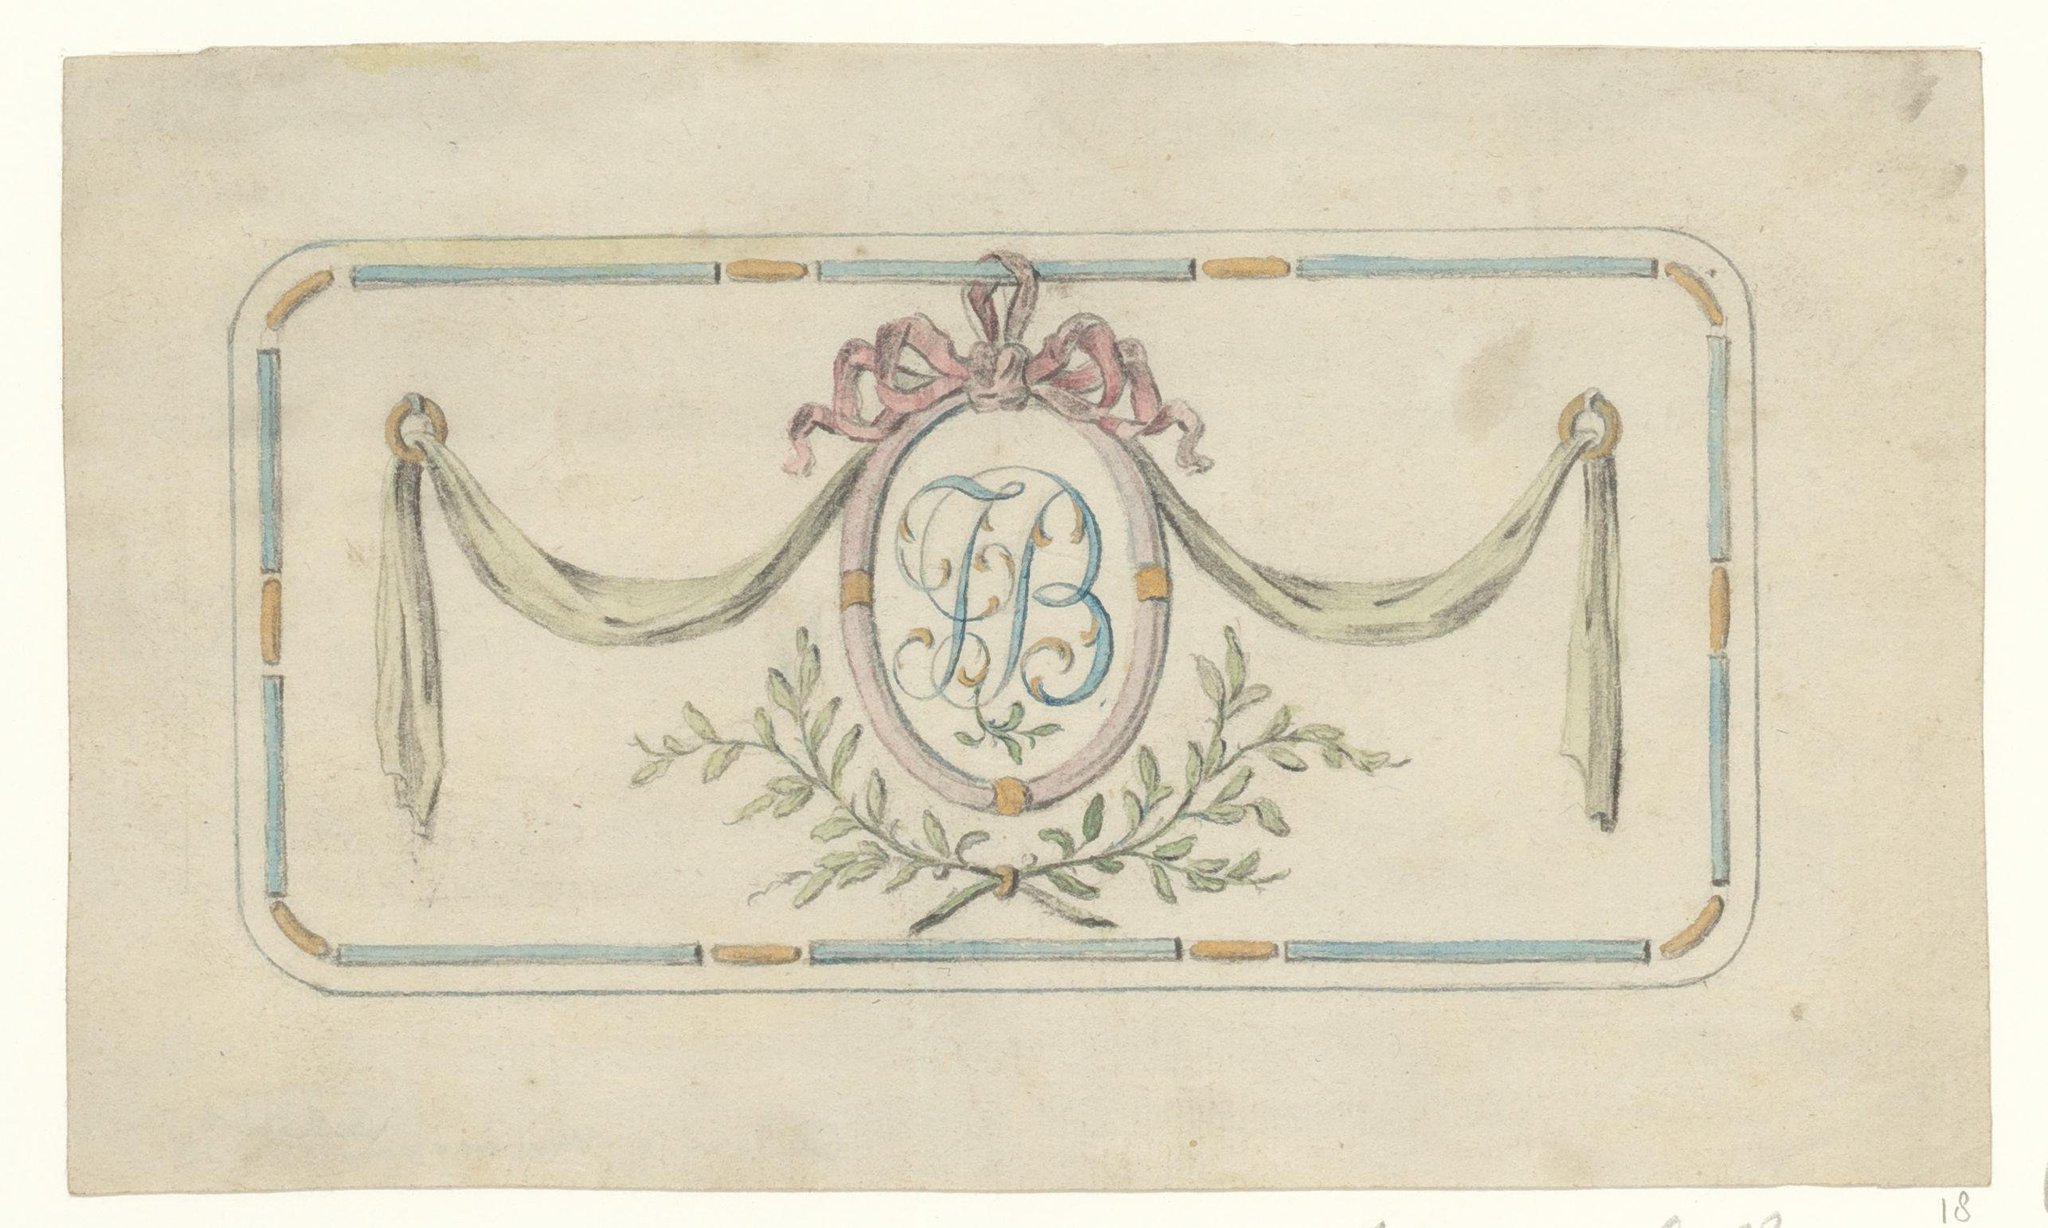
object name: drawing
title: Initialen JB in een medaillon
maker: Anonymous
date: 1750-1799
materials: chalk, paint, paper, watercolor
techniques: brush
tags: flowers, foliage ~ ornament - aa - stylized, initial, ribbon, scroll, banderole ~ ornament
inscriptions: stamp, collector's mark: Lugt 1641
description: Onderwerpsrubrieken binnen de Atlas Zeden en Gewoonten: Schoone kunsten, Sitsen en marmerpapier.